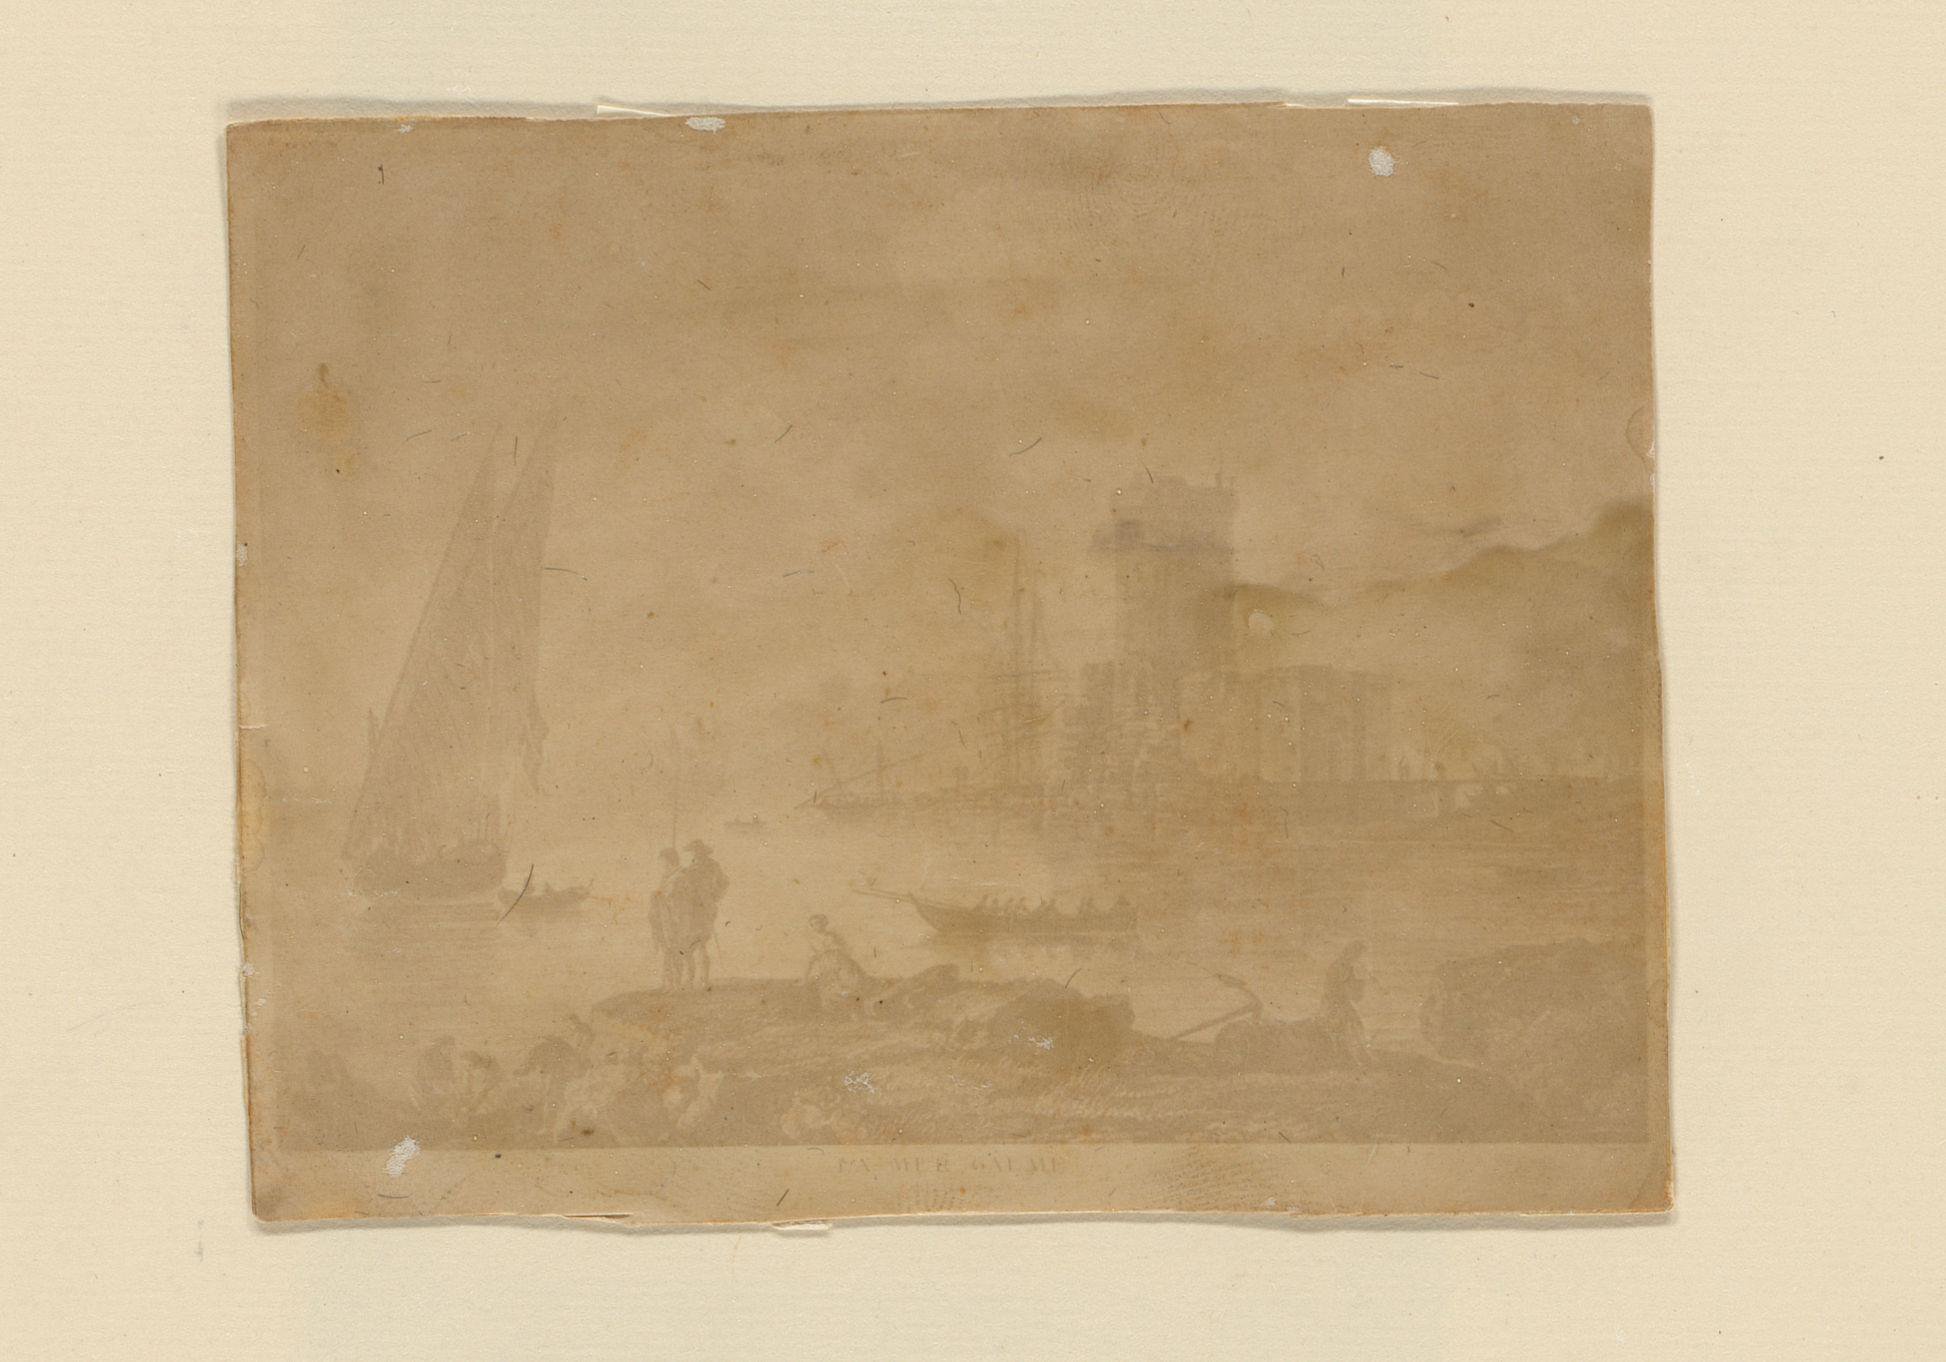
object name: photograph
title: Tekening ('La mer calme') in de stijl van Claude-Joseph Vernet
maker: eduard isaac asser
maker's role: amateurfotograaf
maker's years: 1809-1894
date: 1855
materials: cardboard, paper, photographic support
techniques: salted paper print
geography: amsterdam